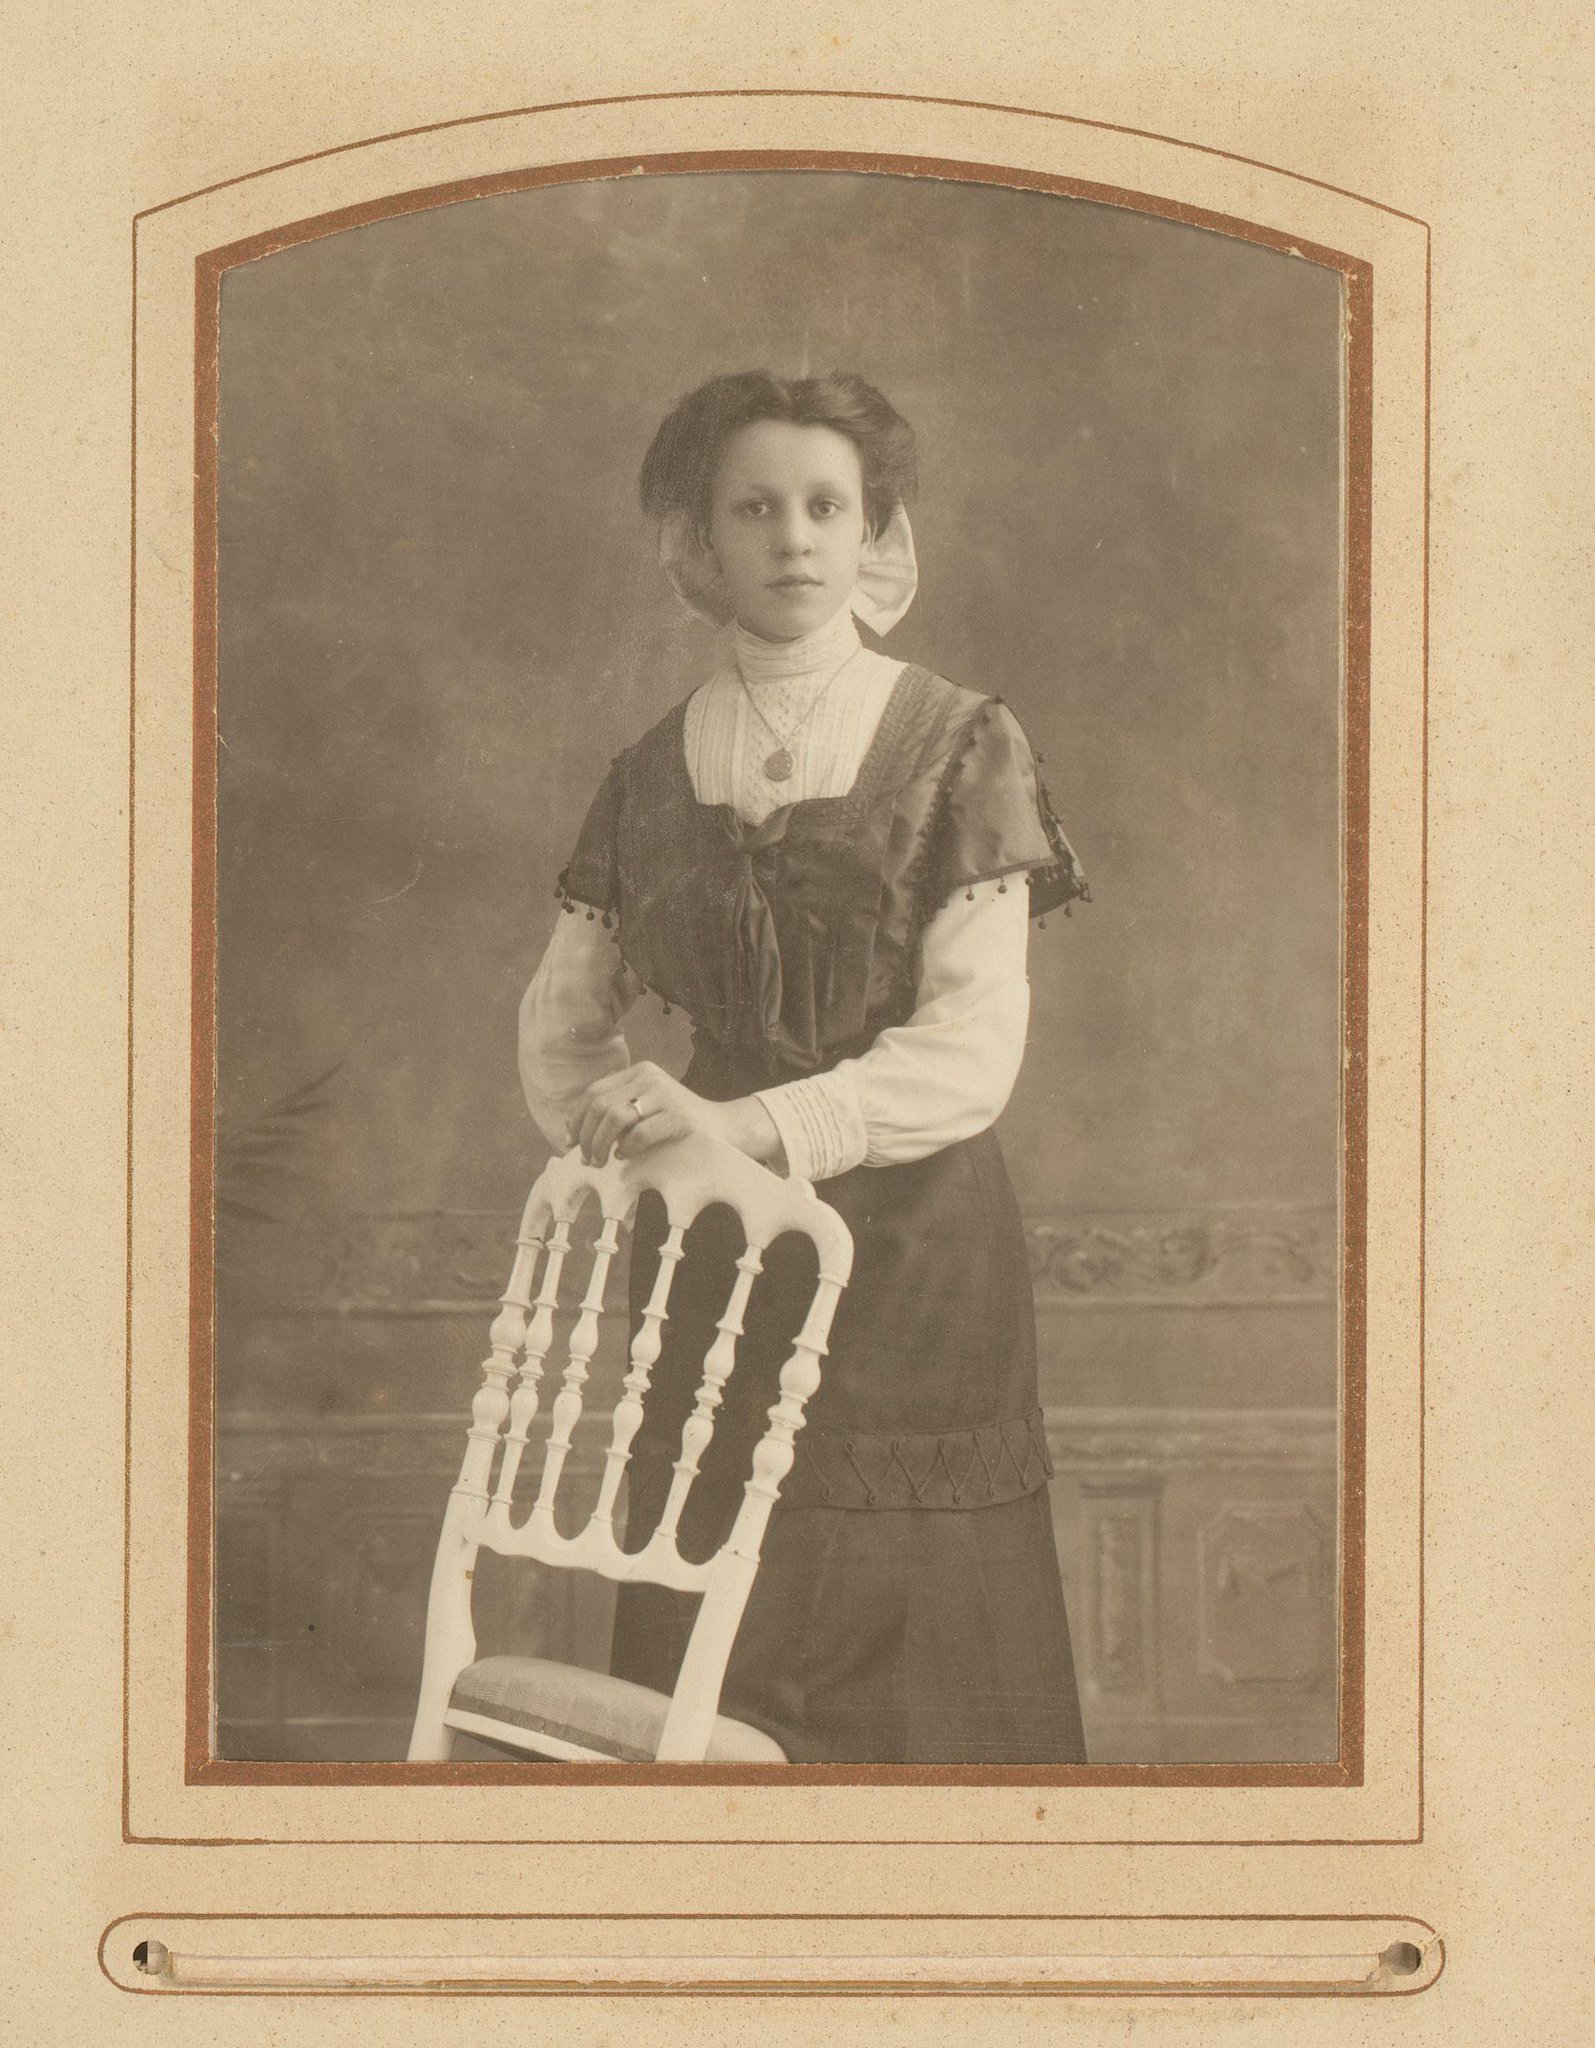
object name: cabinet photograph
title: Portret van een jonge vrouw, staand bij een stoel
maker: Anonymous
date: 1890-1920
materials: cardboard, photographic support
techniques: collodion silver print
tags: adolescent, young woman, maiden, historical persons - bb - woman